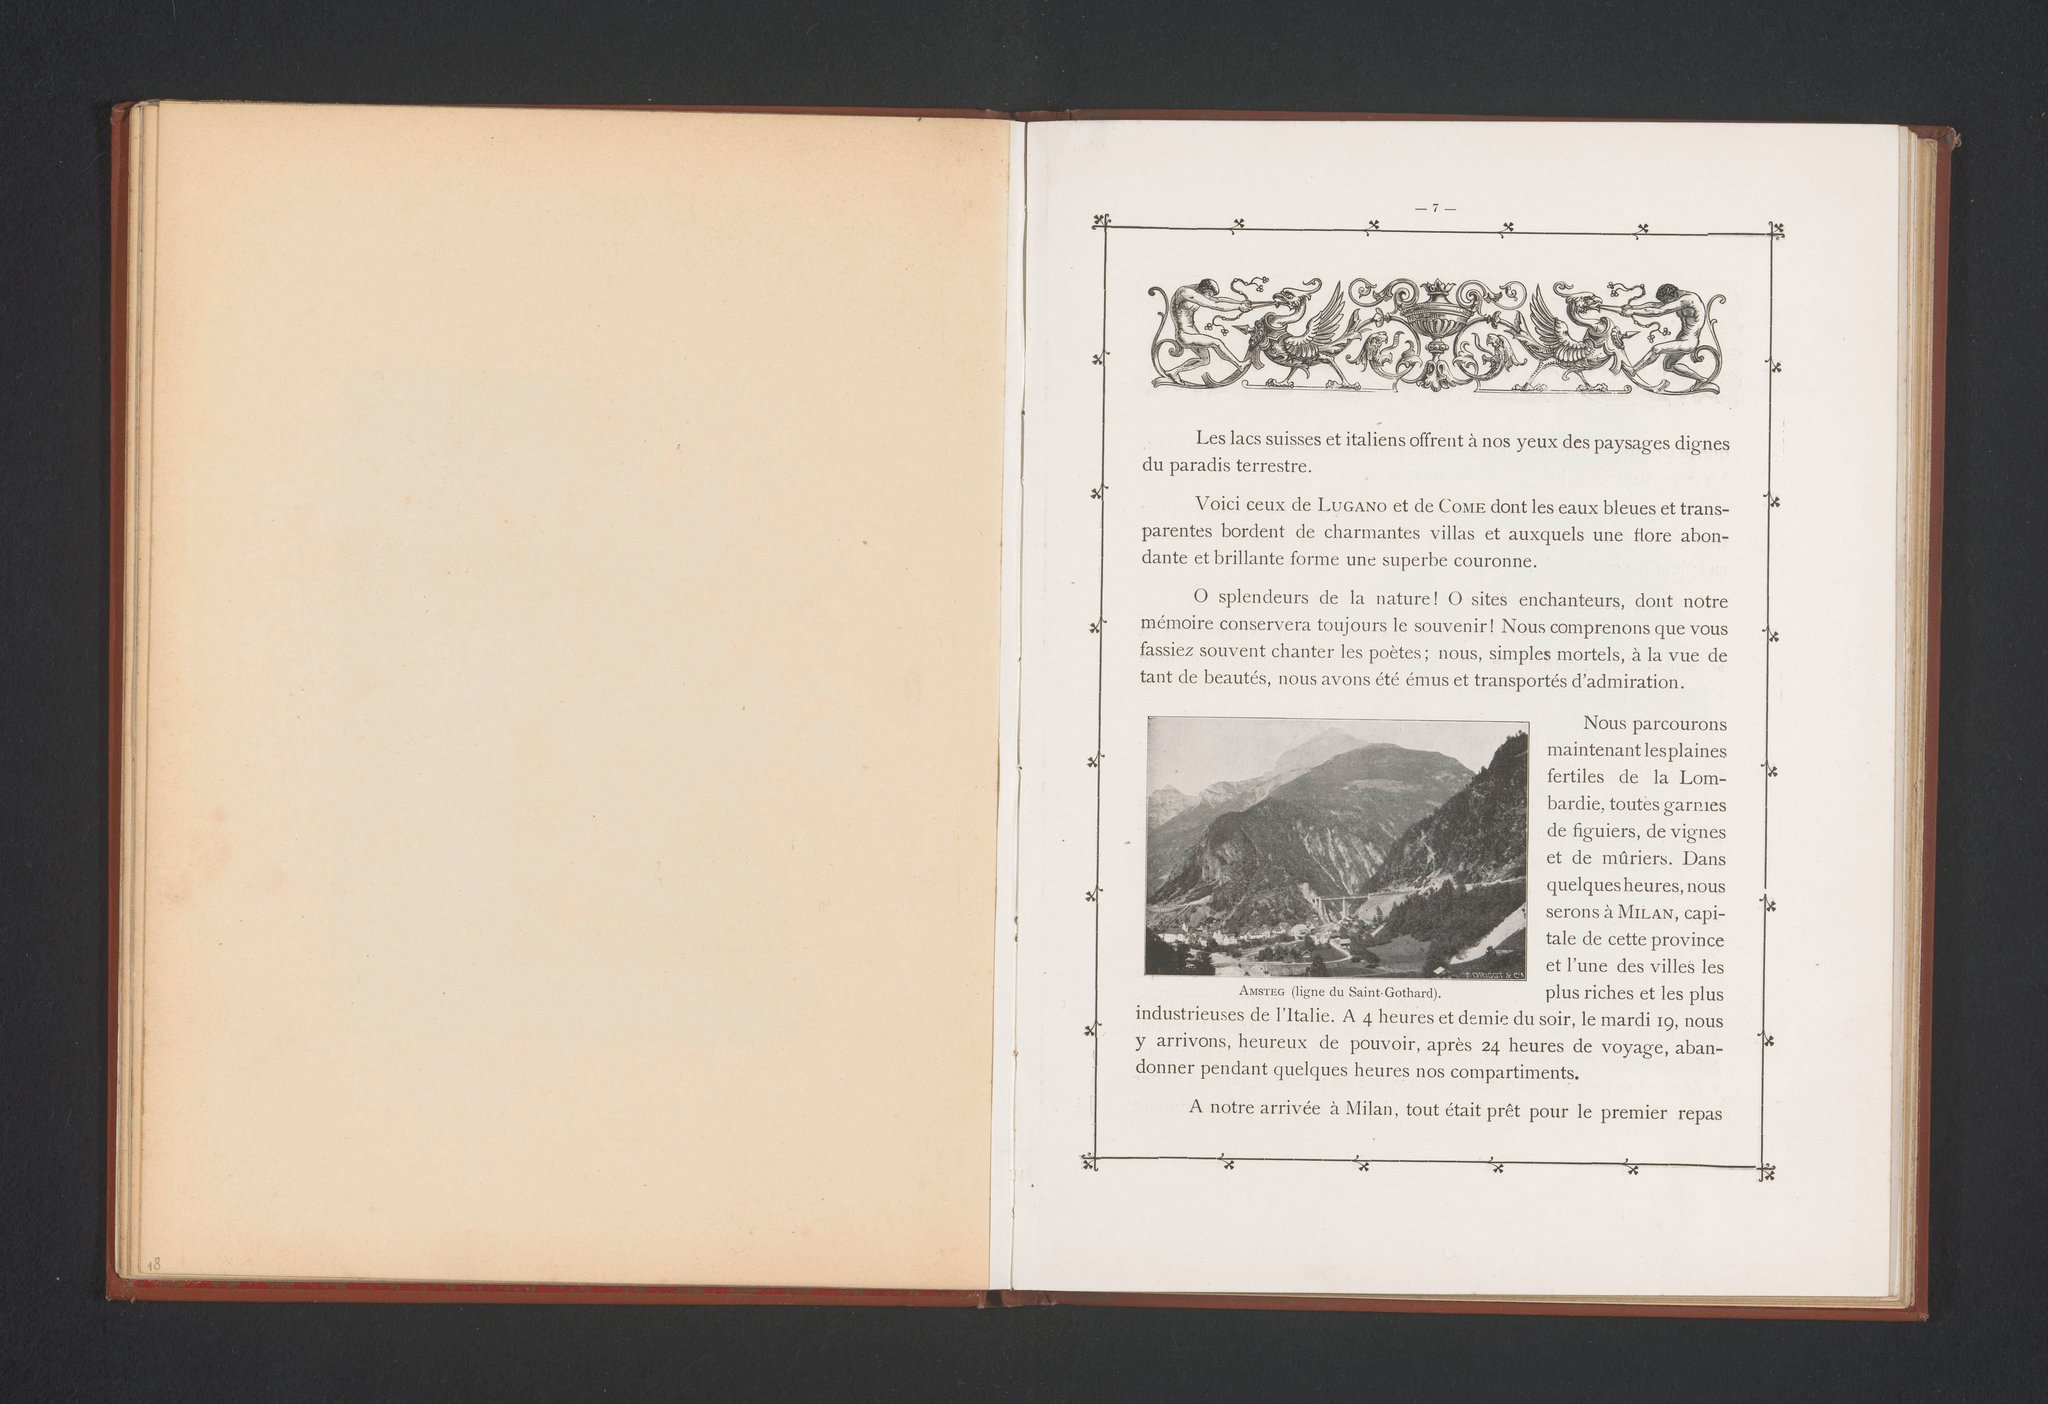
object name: photomechanical print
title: Gezicht op de Gotthardpas bij Amsteg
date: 1893-1898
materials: paper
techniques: autotype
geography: amsteg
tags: dale, valley, mountains